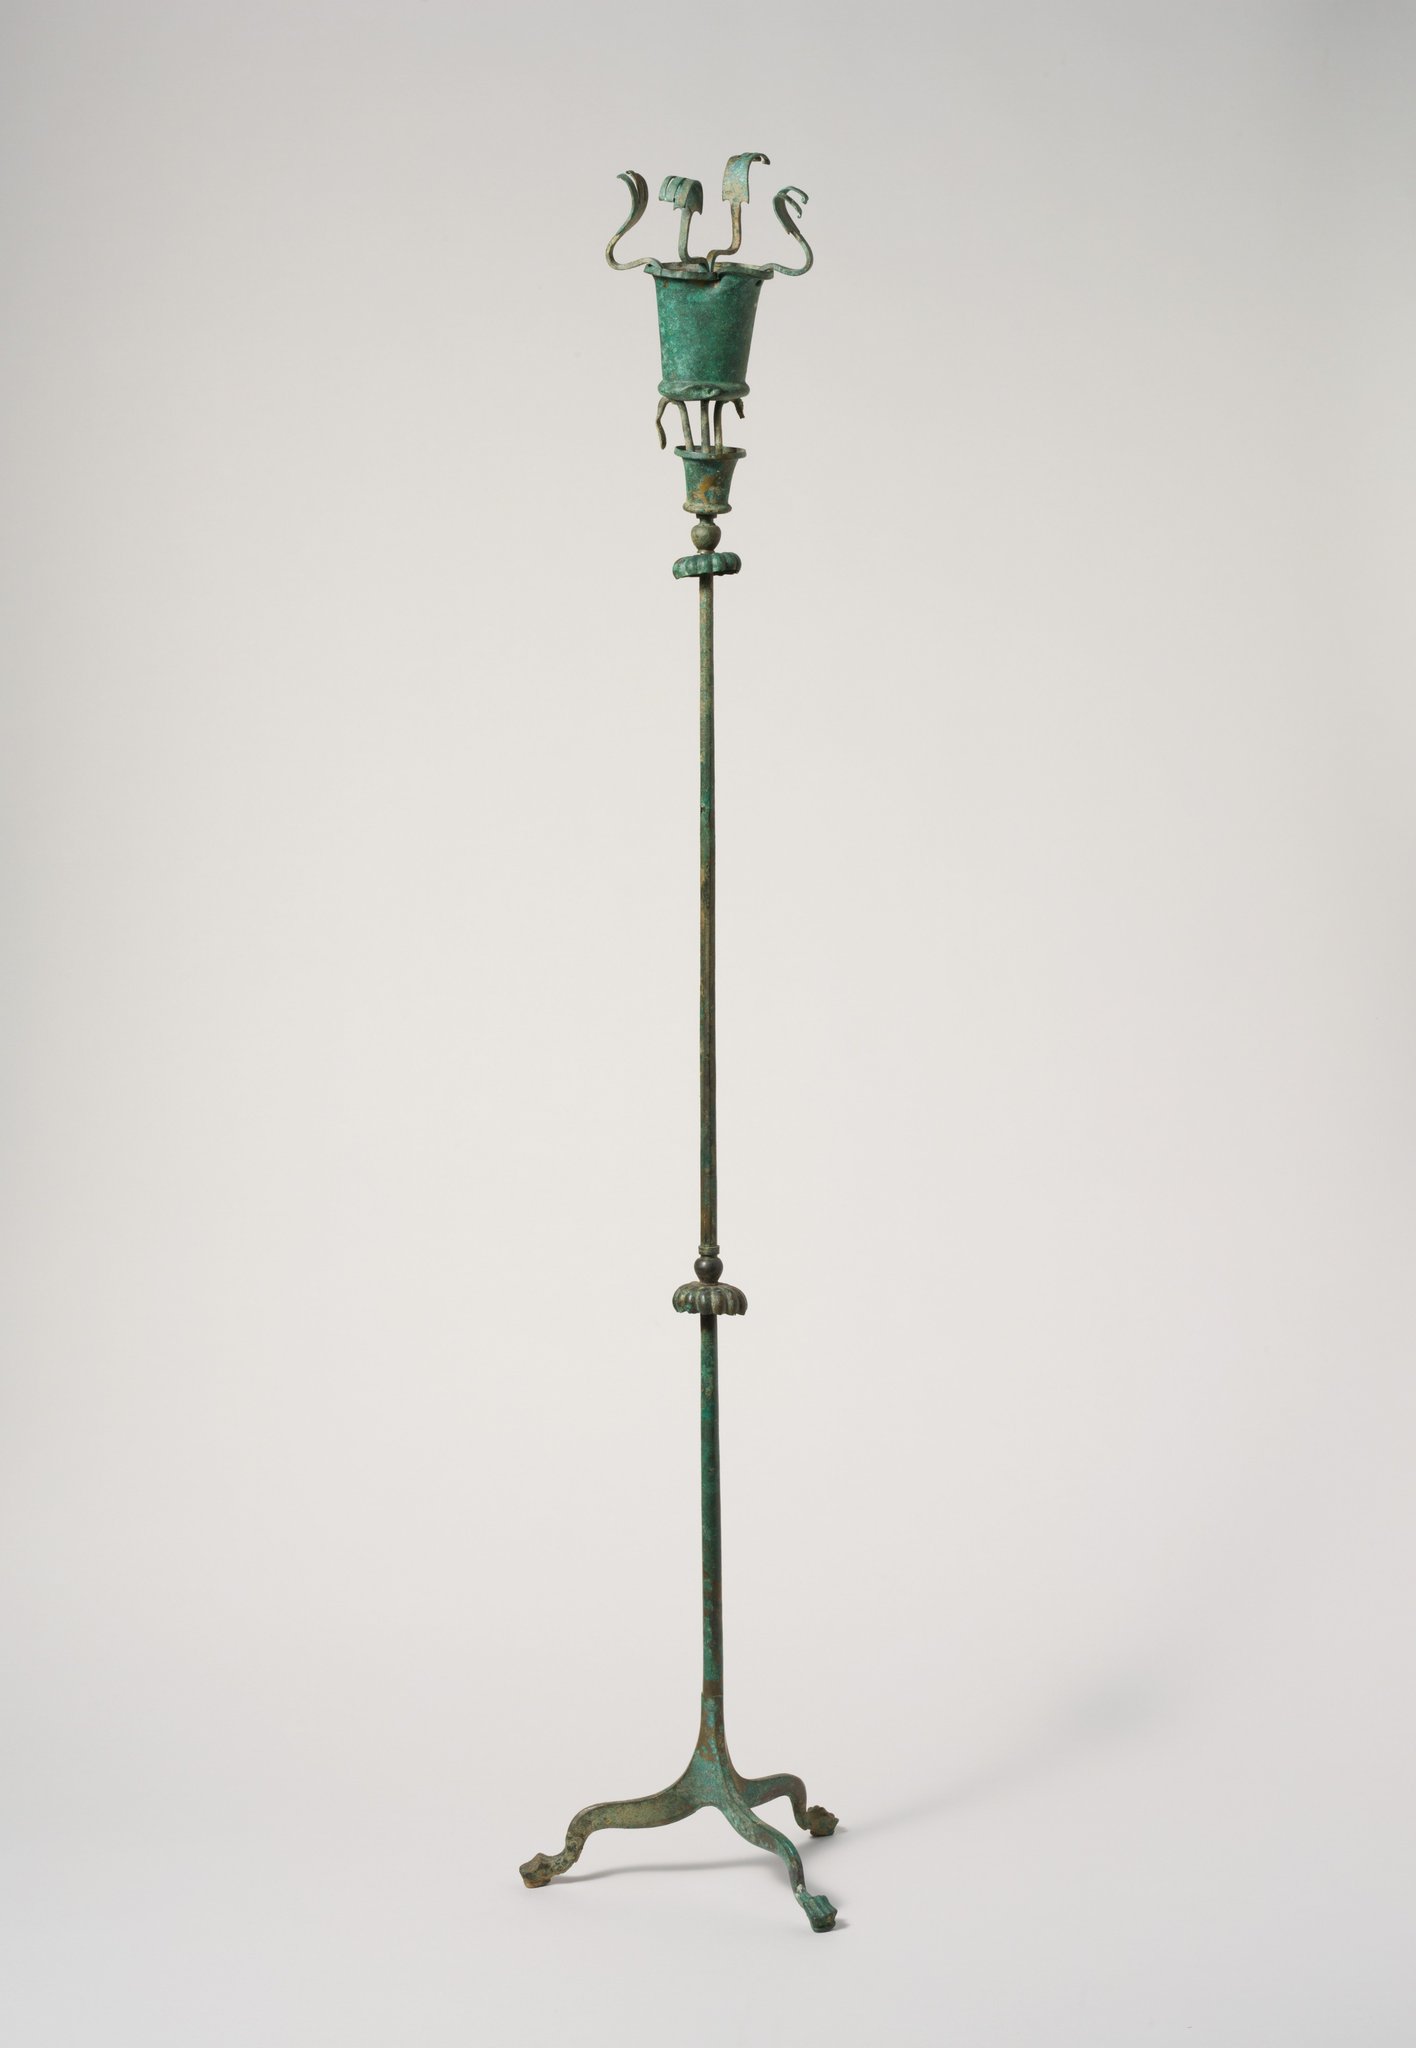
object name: candelabrum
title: Bronze candelabrum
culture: etruscan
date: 550 BCE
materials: bronze